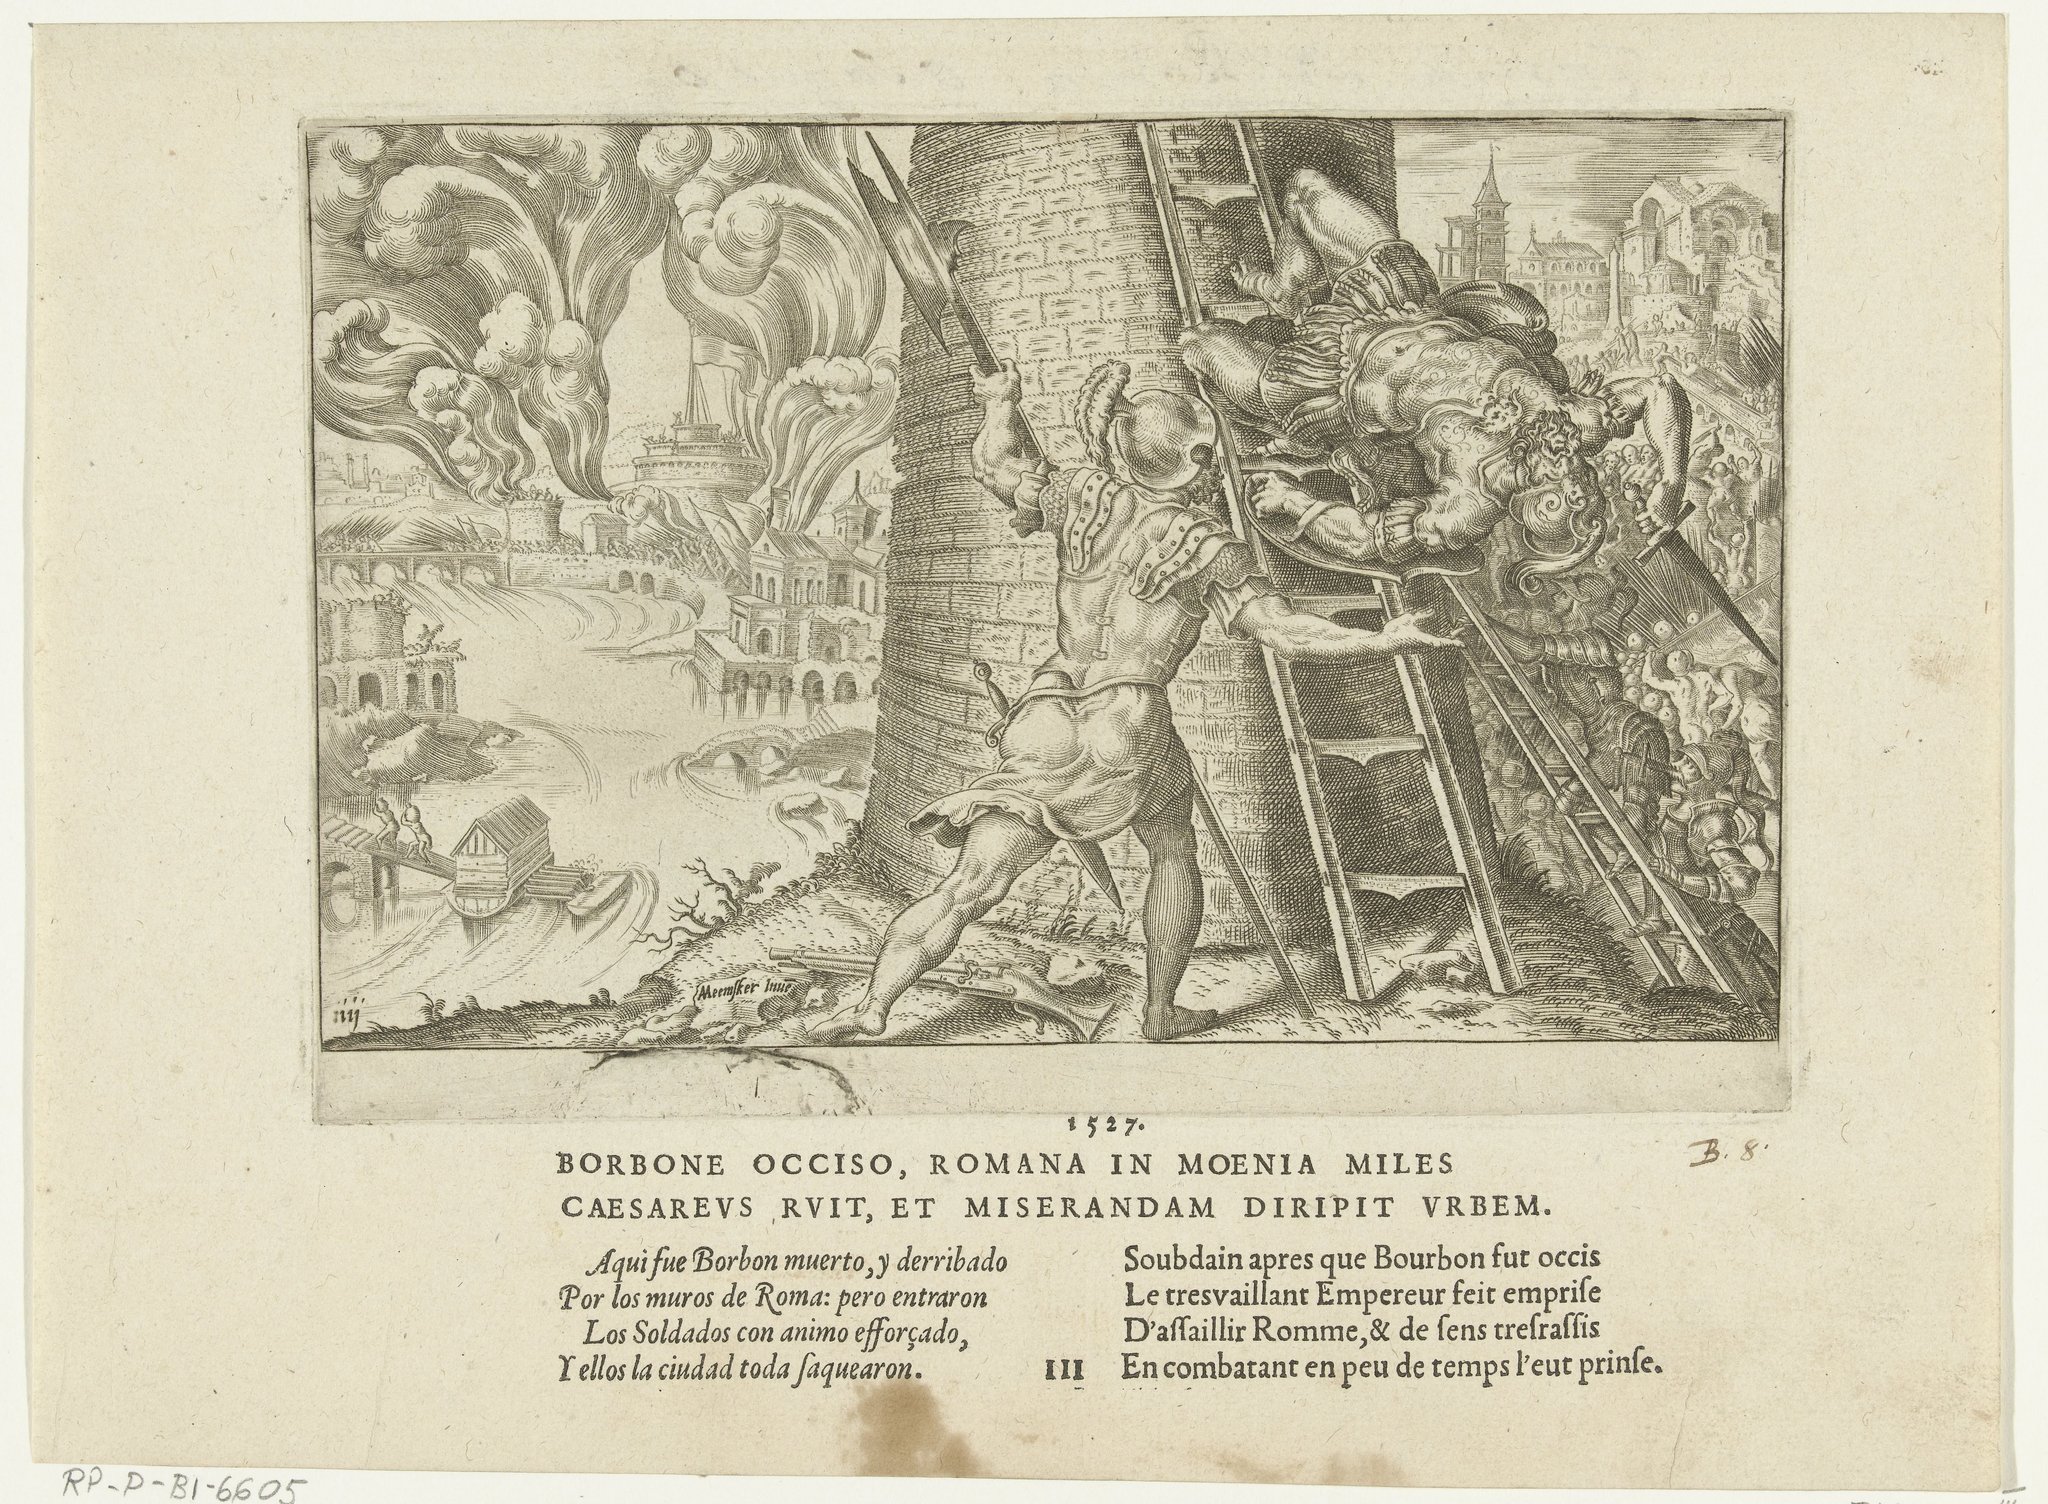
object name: print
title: Triomfen van Karel V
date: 1555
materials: paper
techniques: engraving, etching, letterpress printing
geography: northern netherlands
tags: rome, ghent, charles v (holy roman emperor and king of spain)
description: De dood van Karel van Bourbon tijdens de verovering van Rome, 6 mei 1527. Onderschriften in twee regels Latijn, vier regels Spaans en vier regels Frans.